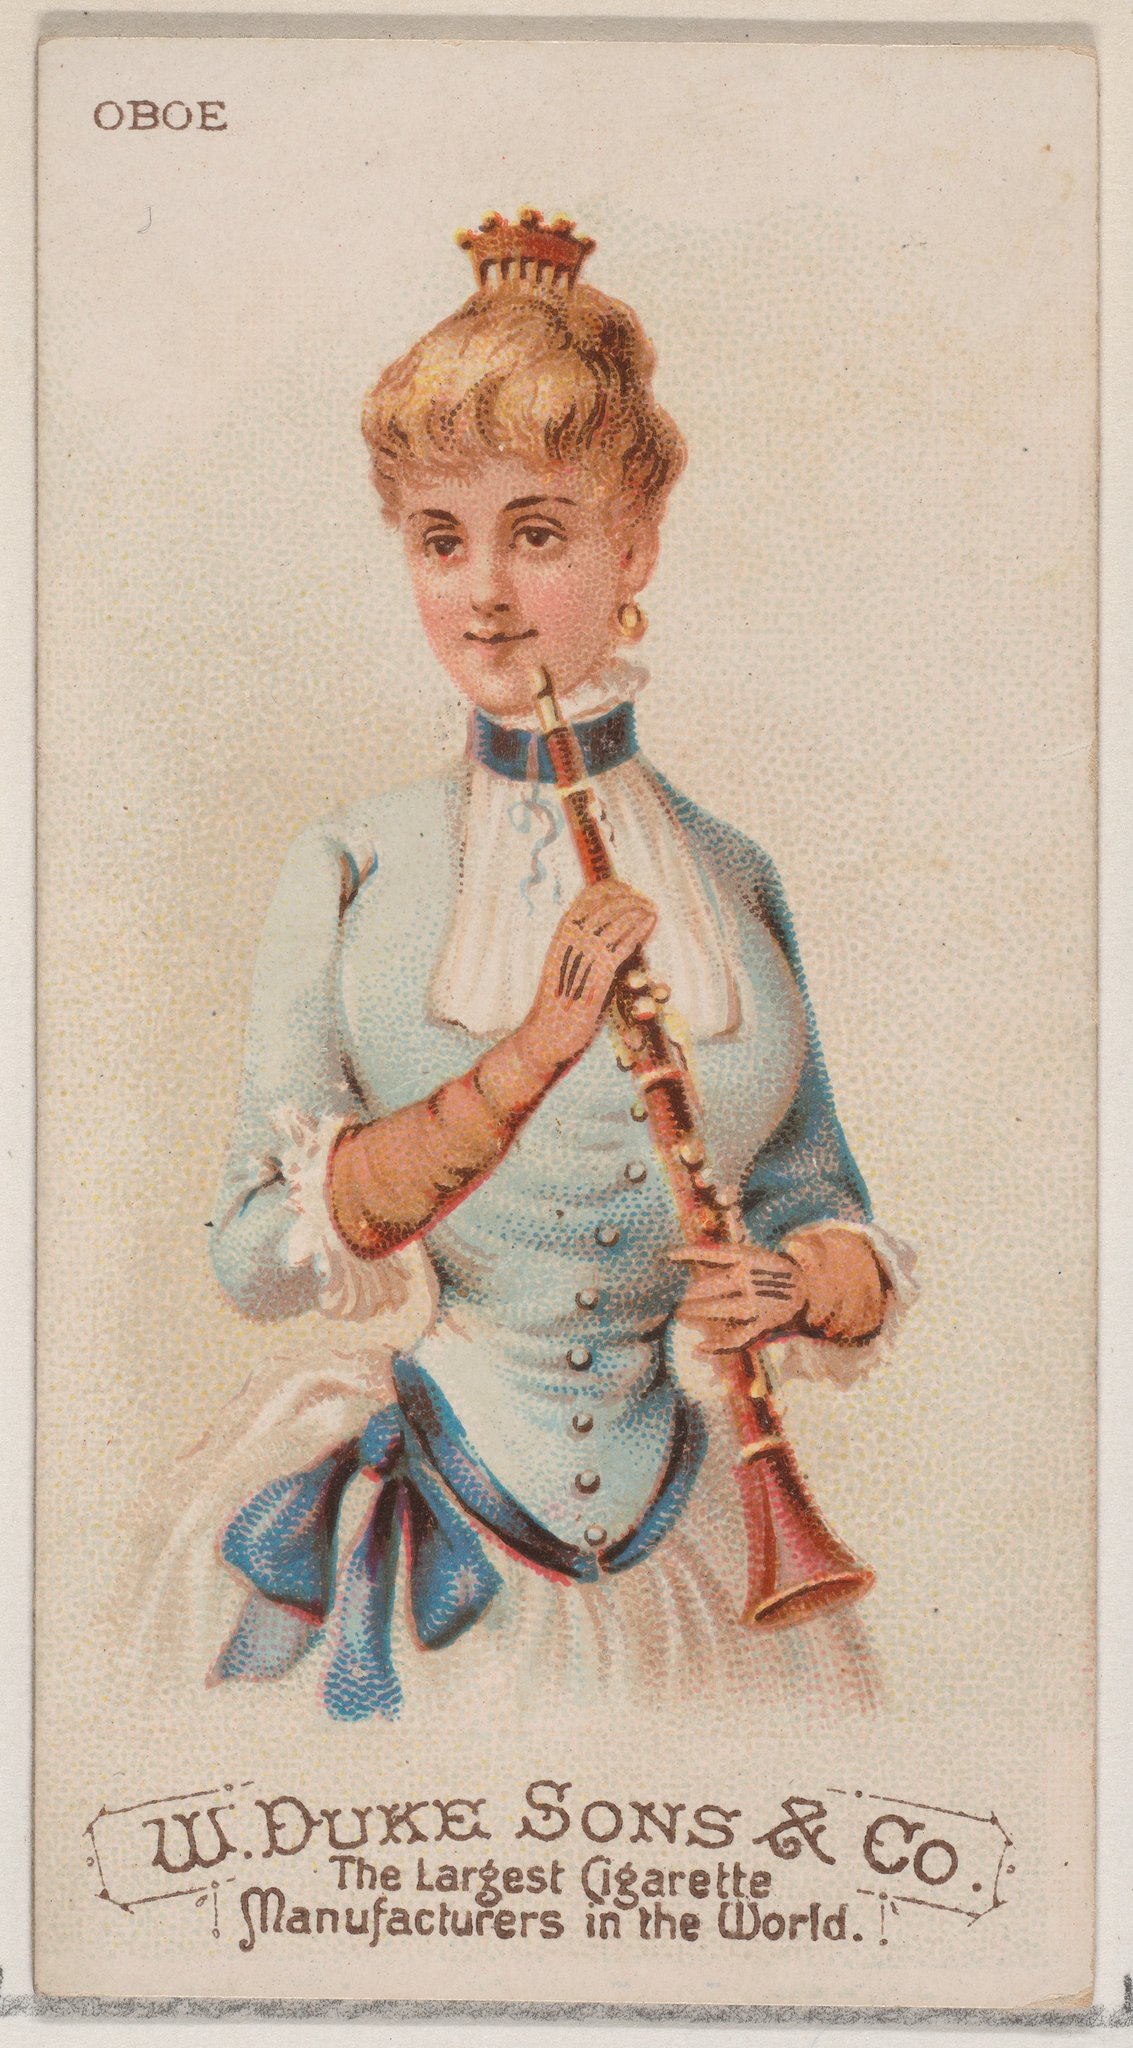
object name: print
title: Oboe, from the Musical Instruments series (N82) for Duke brand cigarettes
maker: w. duke, sons & co.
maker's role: publisher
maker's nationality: american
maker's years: 1870-1920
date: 1888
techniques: color lithograph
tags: musical instruments,women,musicians